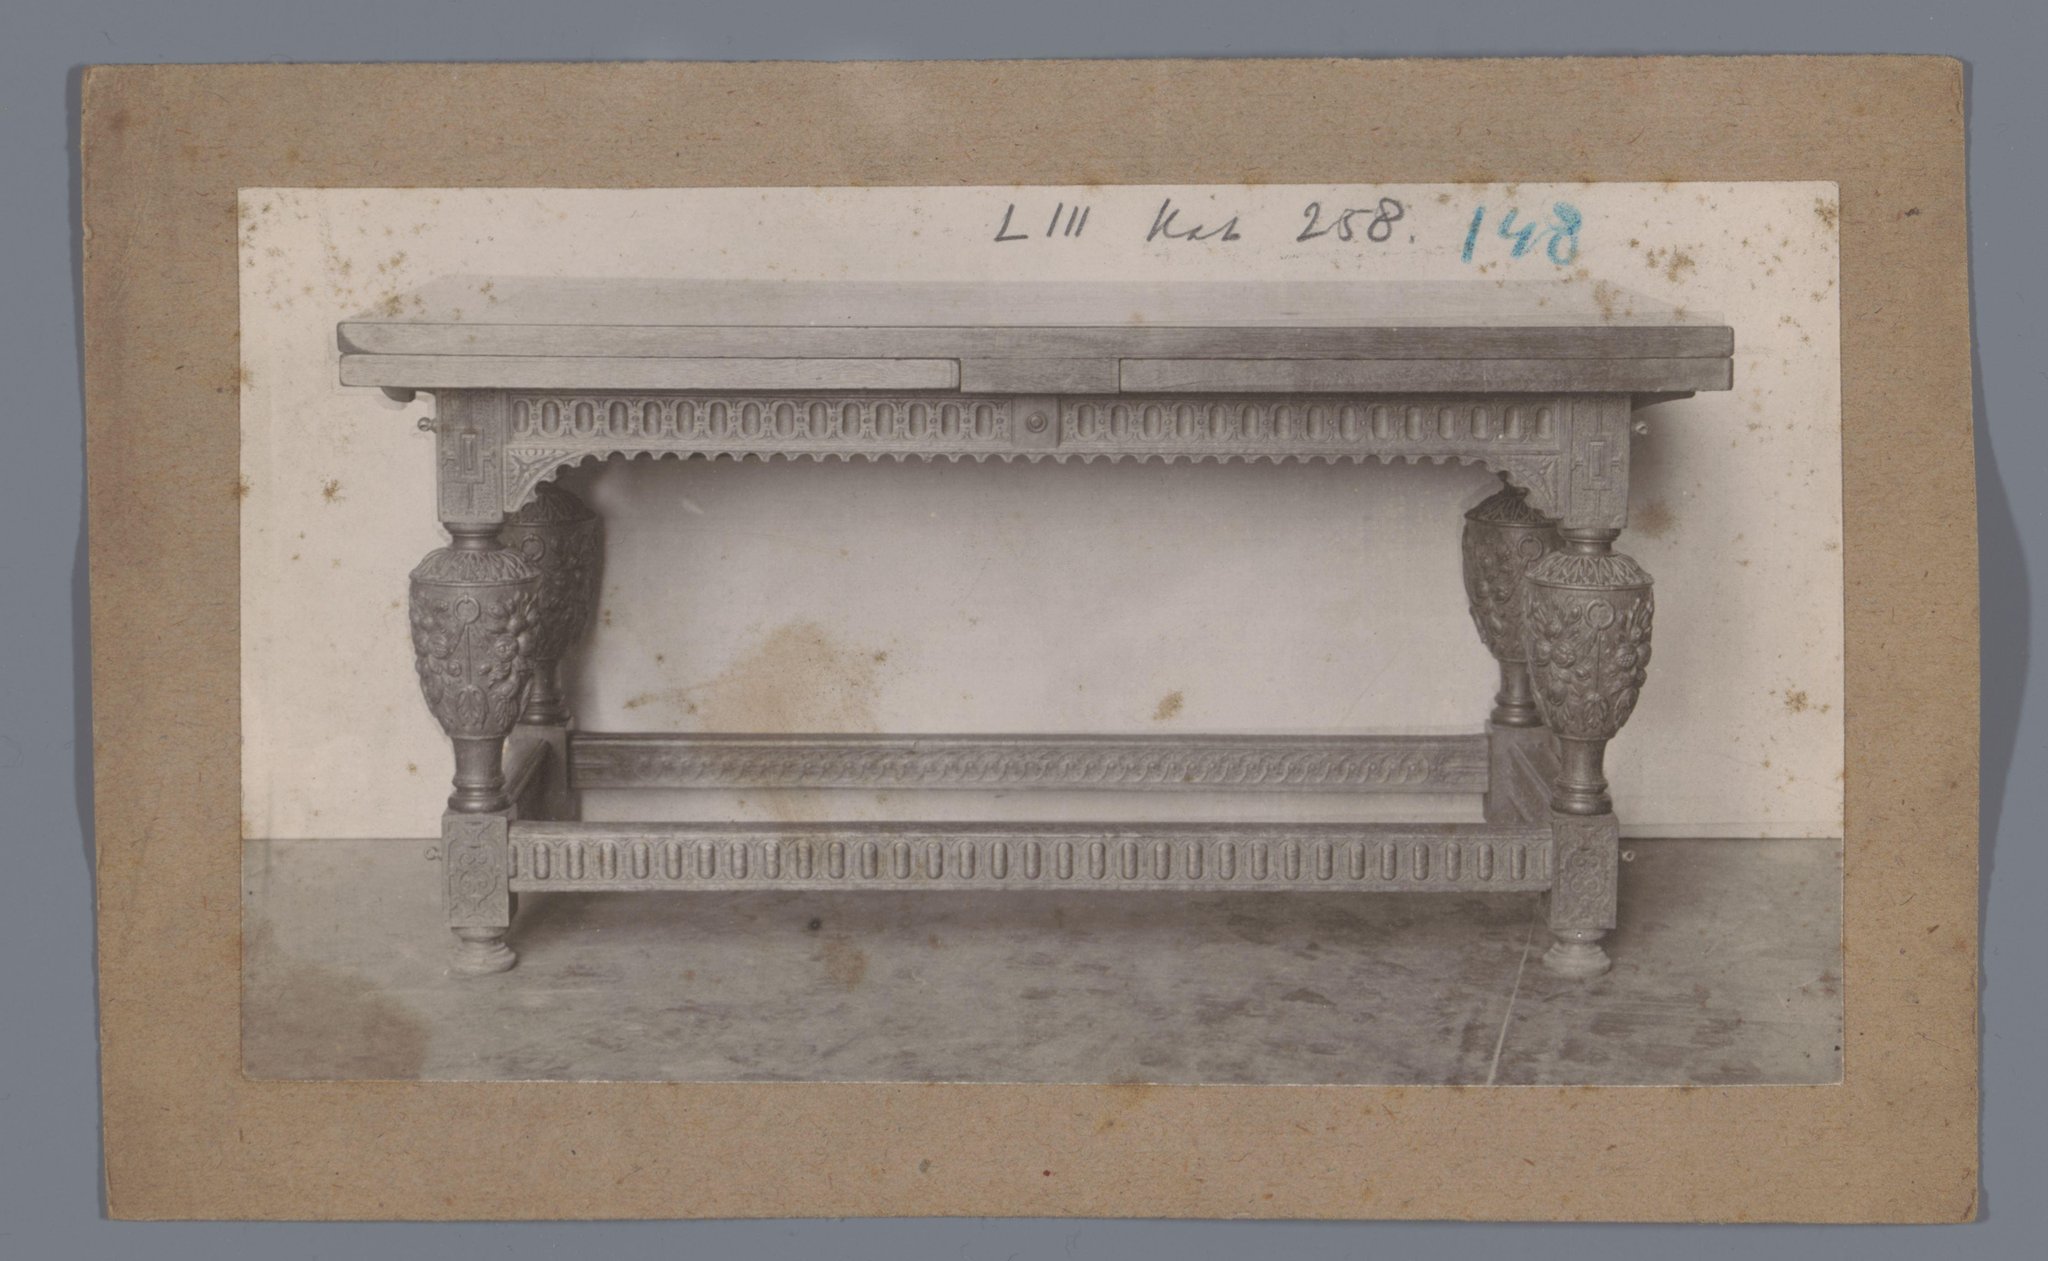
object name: photograph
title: Trektafel gedecoreerd met fruit (vermoedelijk) in het Rijksmuseum te Amsterdam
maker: Anonymous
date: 1875-1900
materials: photographic support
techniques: matte daylight collodion silver print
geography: amsterdam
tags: table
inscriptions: number: ‘LIII kat 258 148’, collector's mark: ‘Instituut voor kunst-nijverheidsonderwijs Gabriël Metsustraat No. 16, Amsterdam’